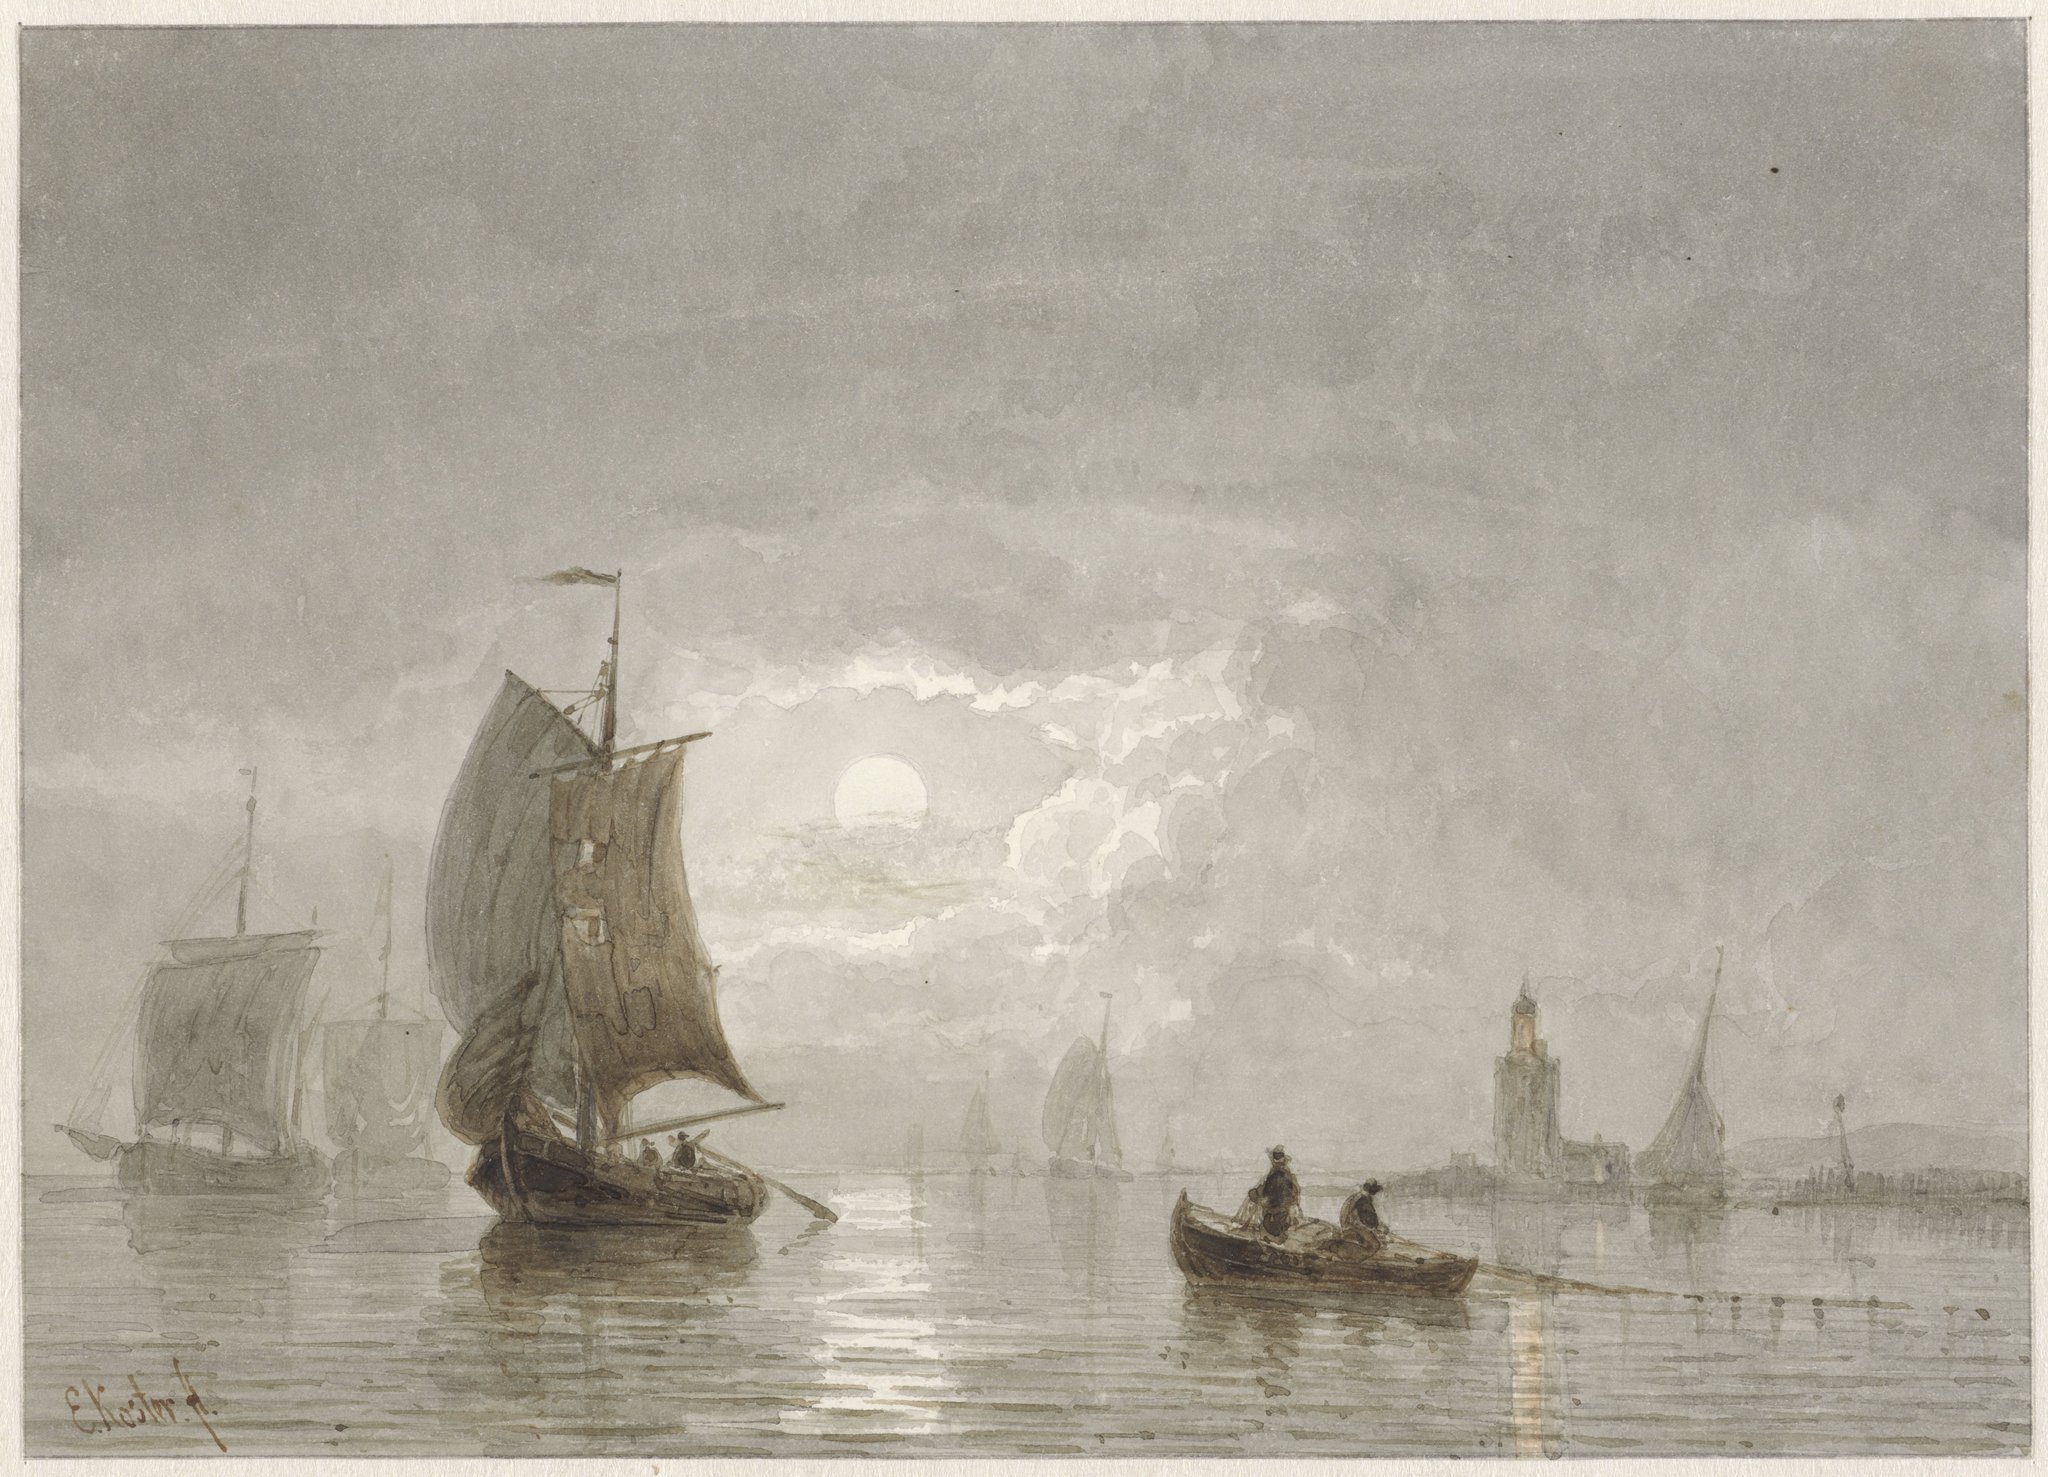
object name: drawing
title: Zeilschepen bij maanlicht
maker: everhardus koster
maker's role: draughtsman, painter, print maker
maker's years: 1817-1892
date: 1827-1892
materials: paper, pencil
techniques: brush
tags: sailing-ship, sailing-boat, river